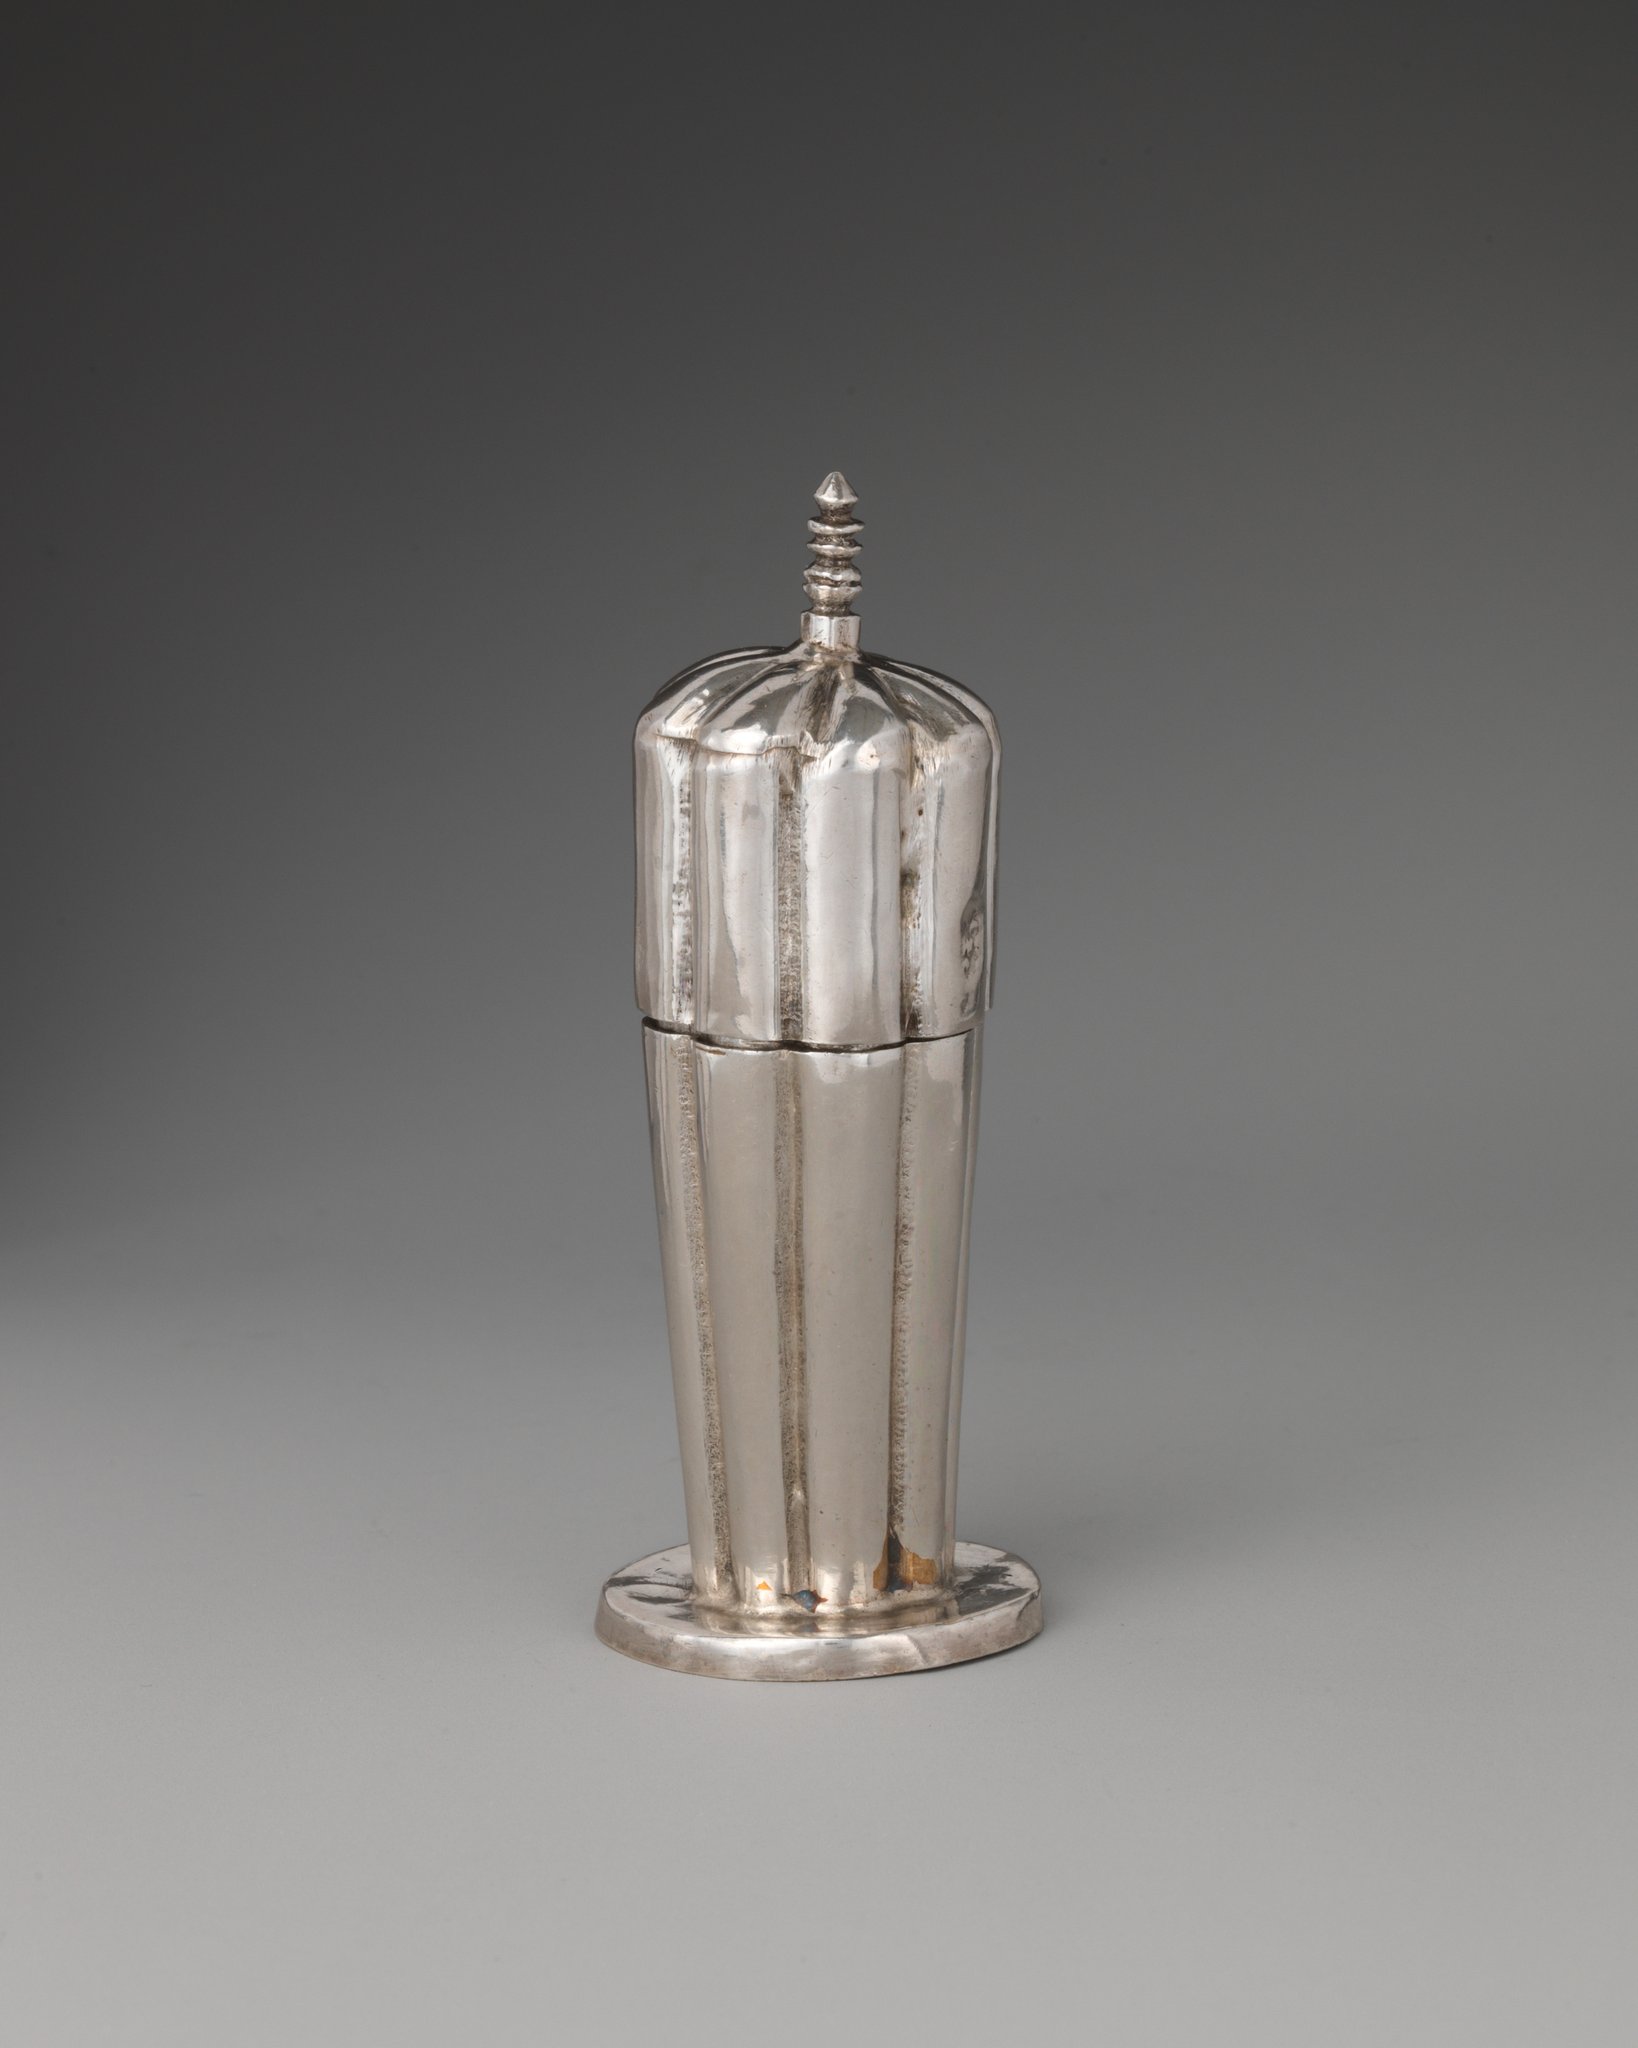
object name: knifebox with cover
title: Miniature knifebox with cover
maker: george manjoy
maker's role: maker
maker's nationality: british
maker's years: 1685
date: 1667-1700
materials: silver